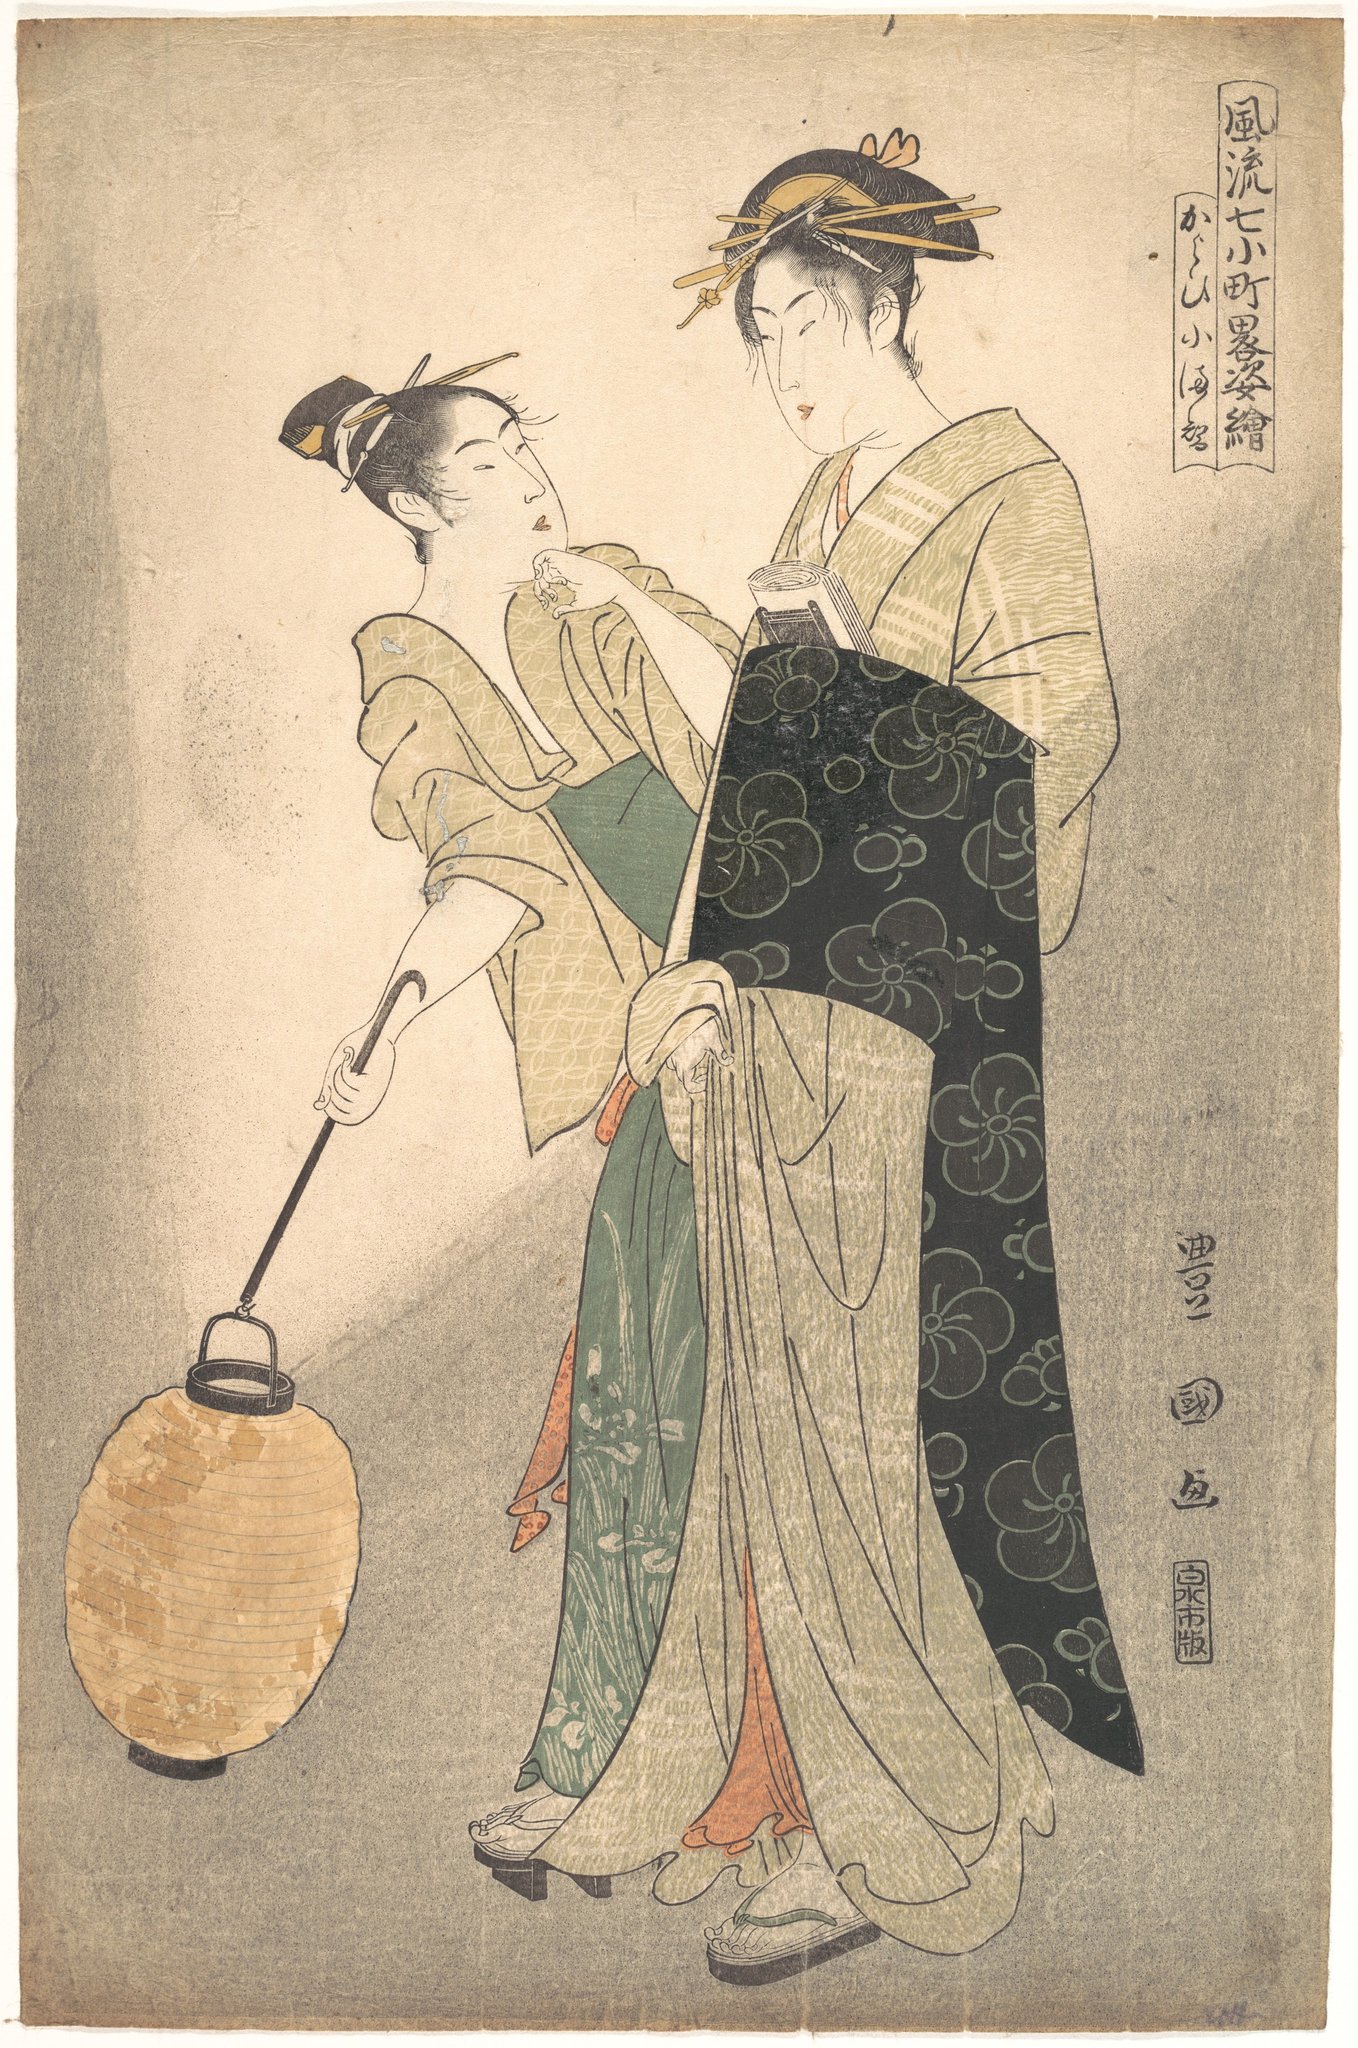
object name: print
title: Kayoi Komachi, from the series "Seven Episodes of the Poet Komachi"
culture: japanese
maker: utagawa toyokuni i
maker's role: artist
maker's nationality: japanese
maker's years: 1769-1825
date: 1795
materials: ink, paper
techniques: woodblock print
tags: women